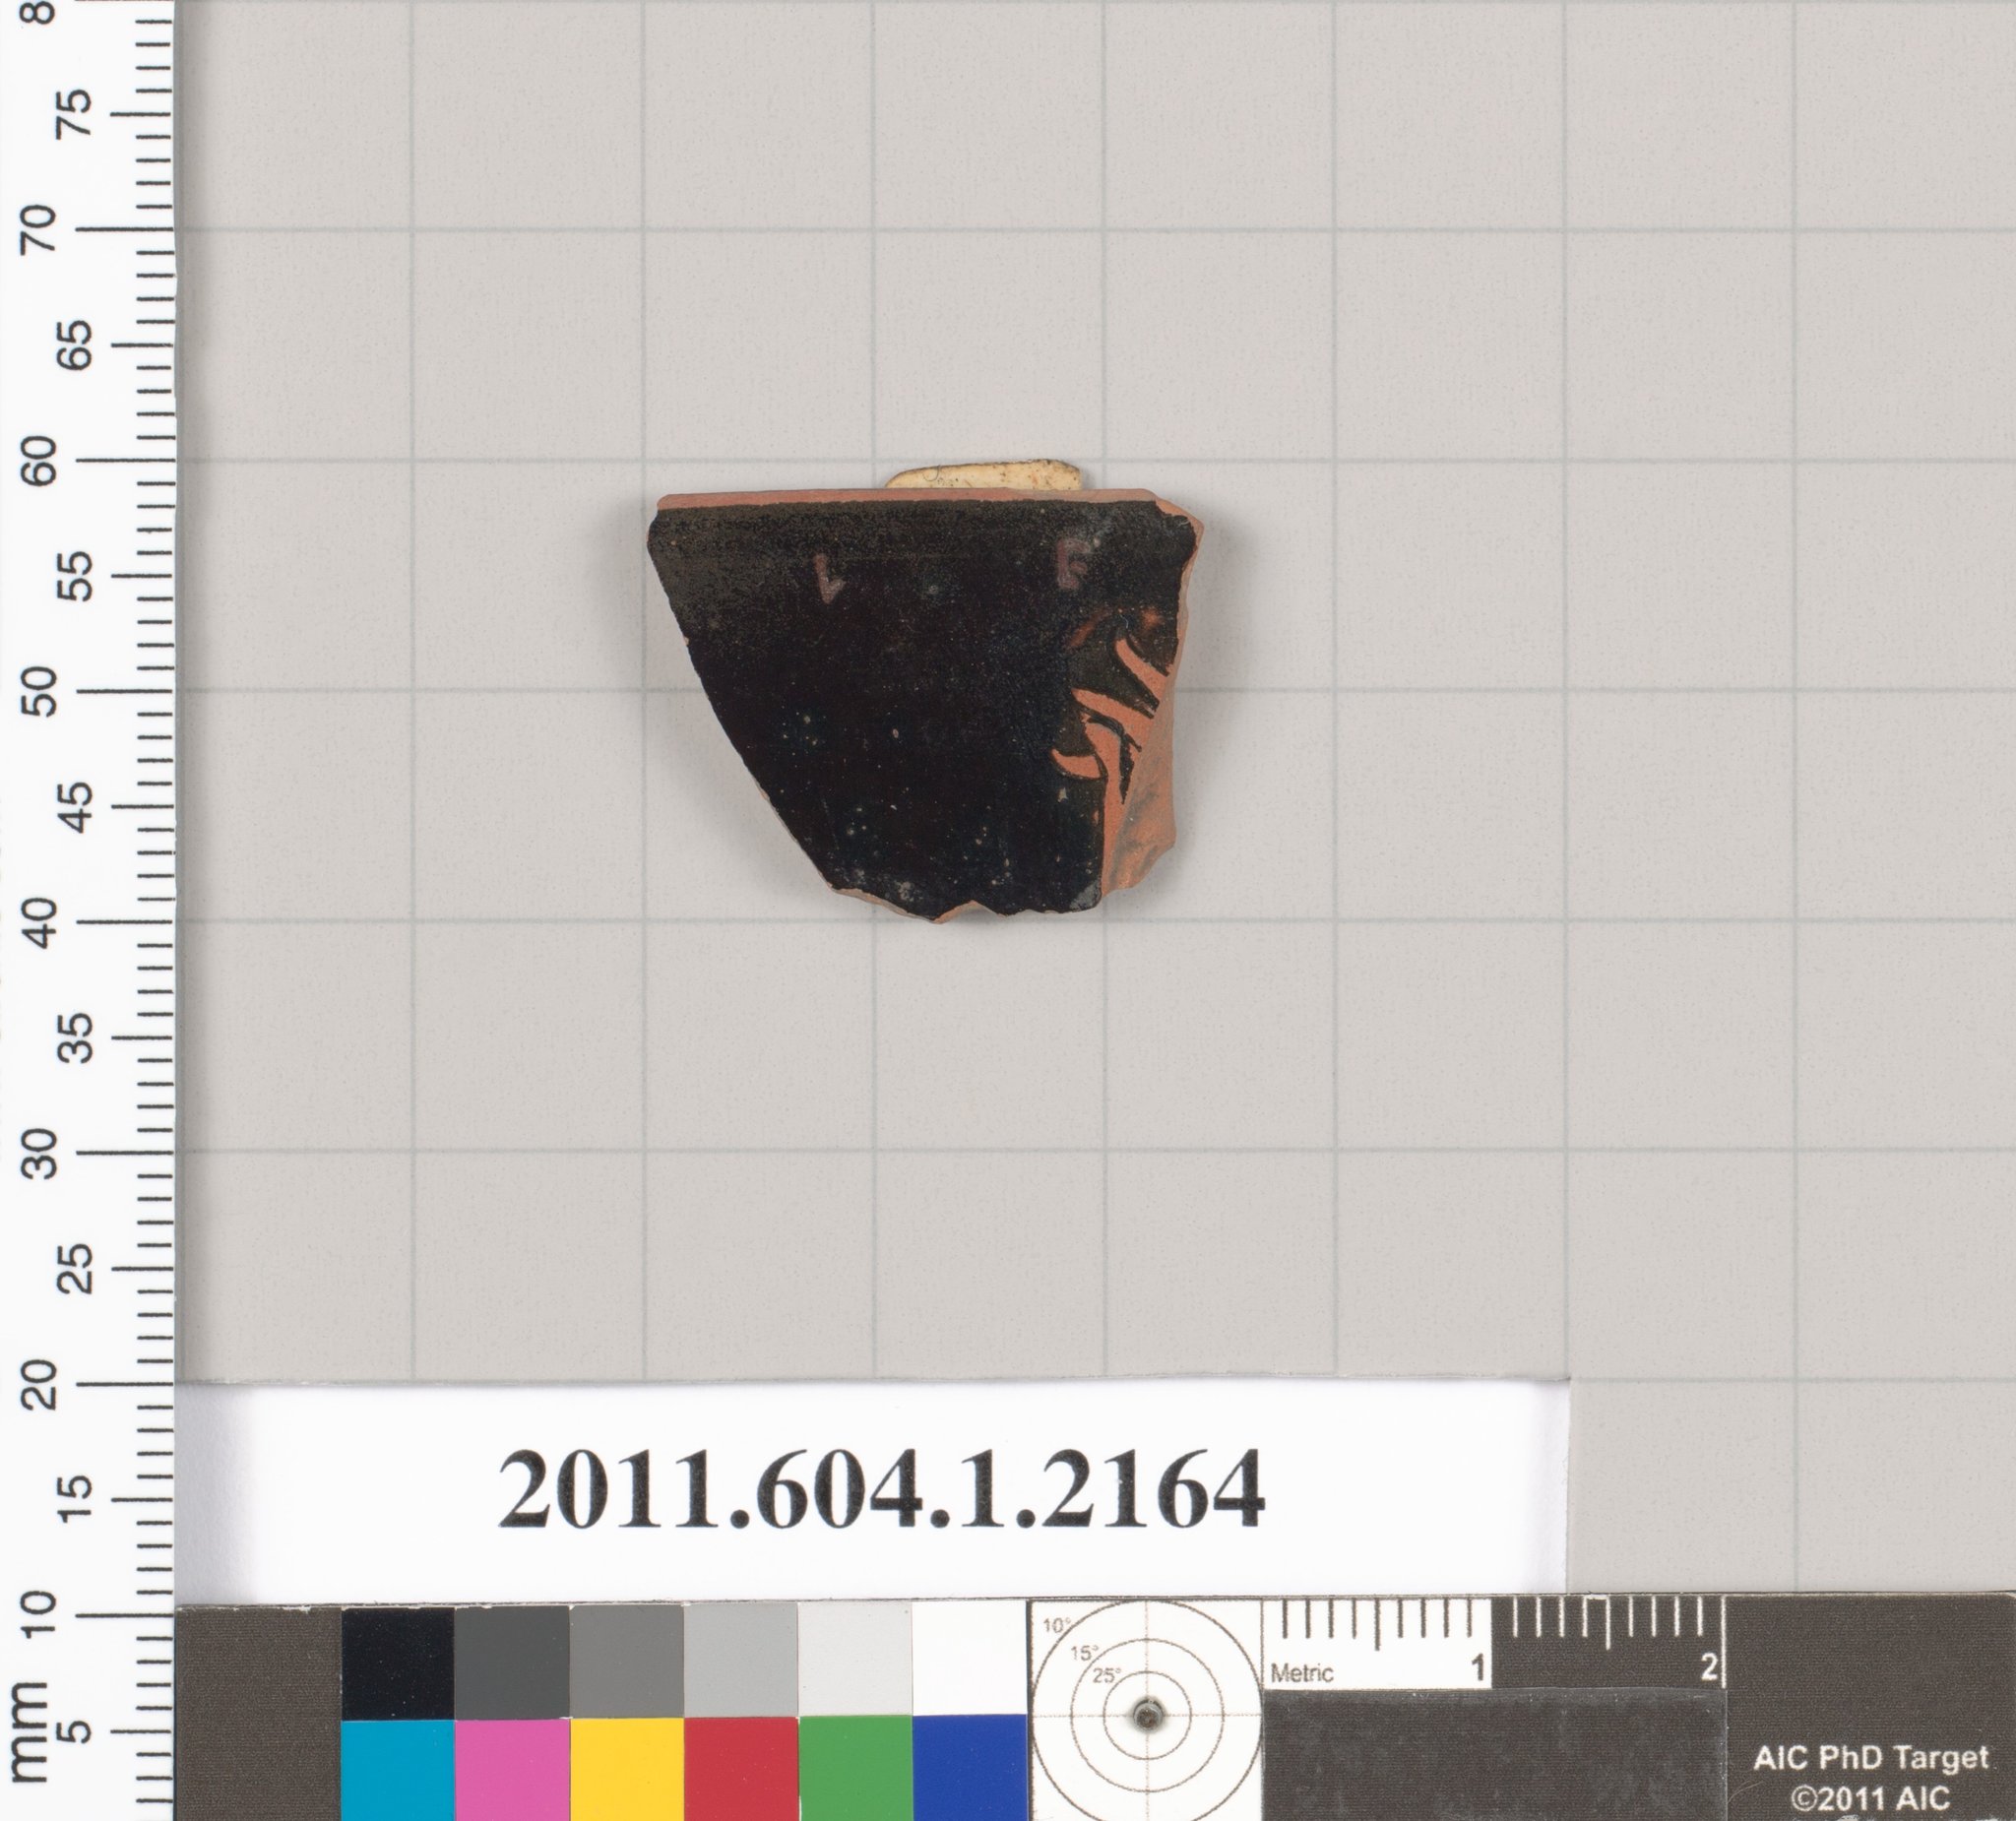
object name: kylix fragment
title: Terracotta rim fragment of a kylix (drinking cup)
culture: greek, attic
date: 490-480 BCE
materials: terracotta